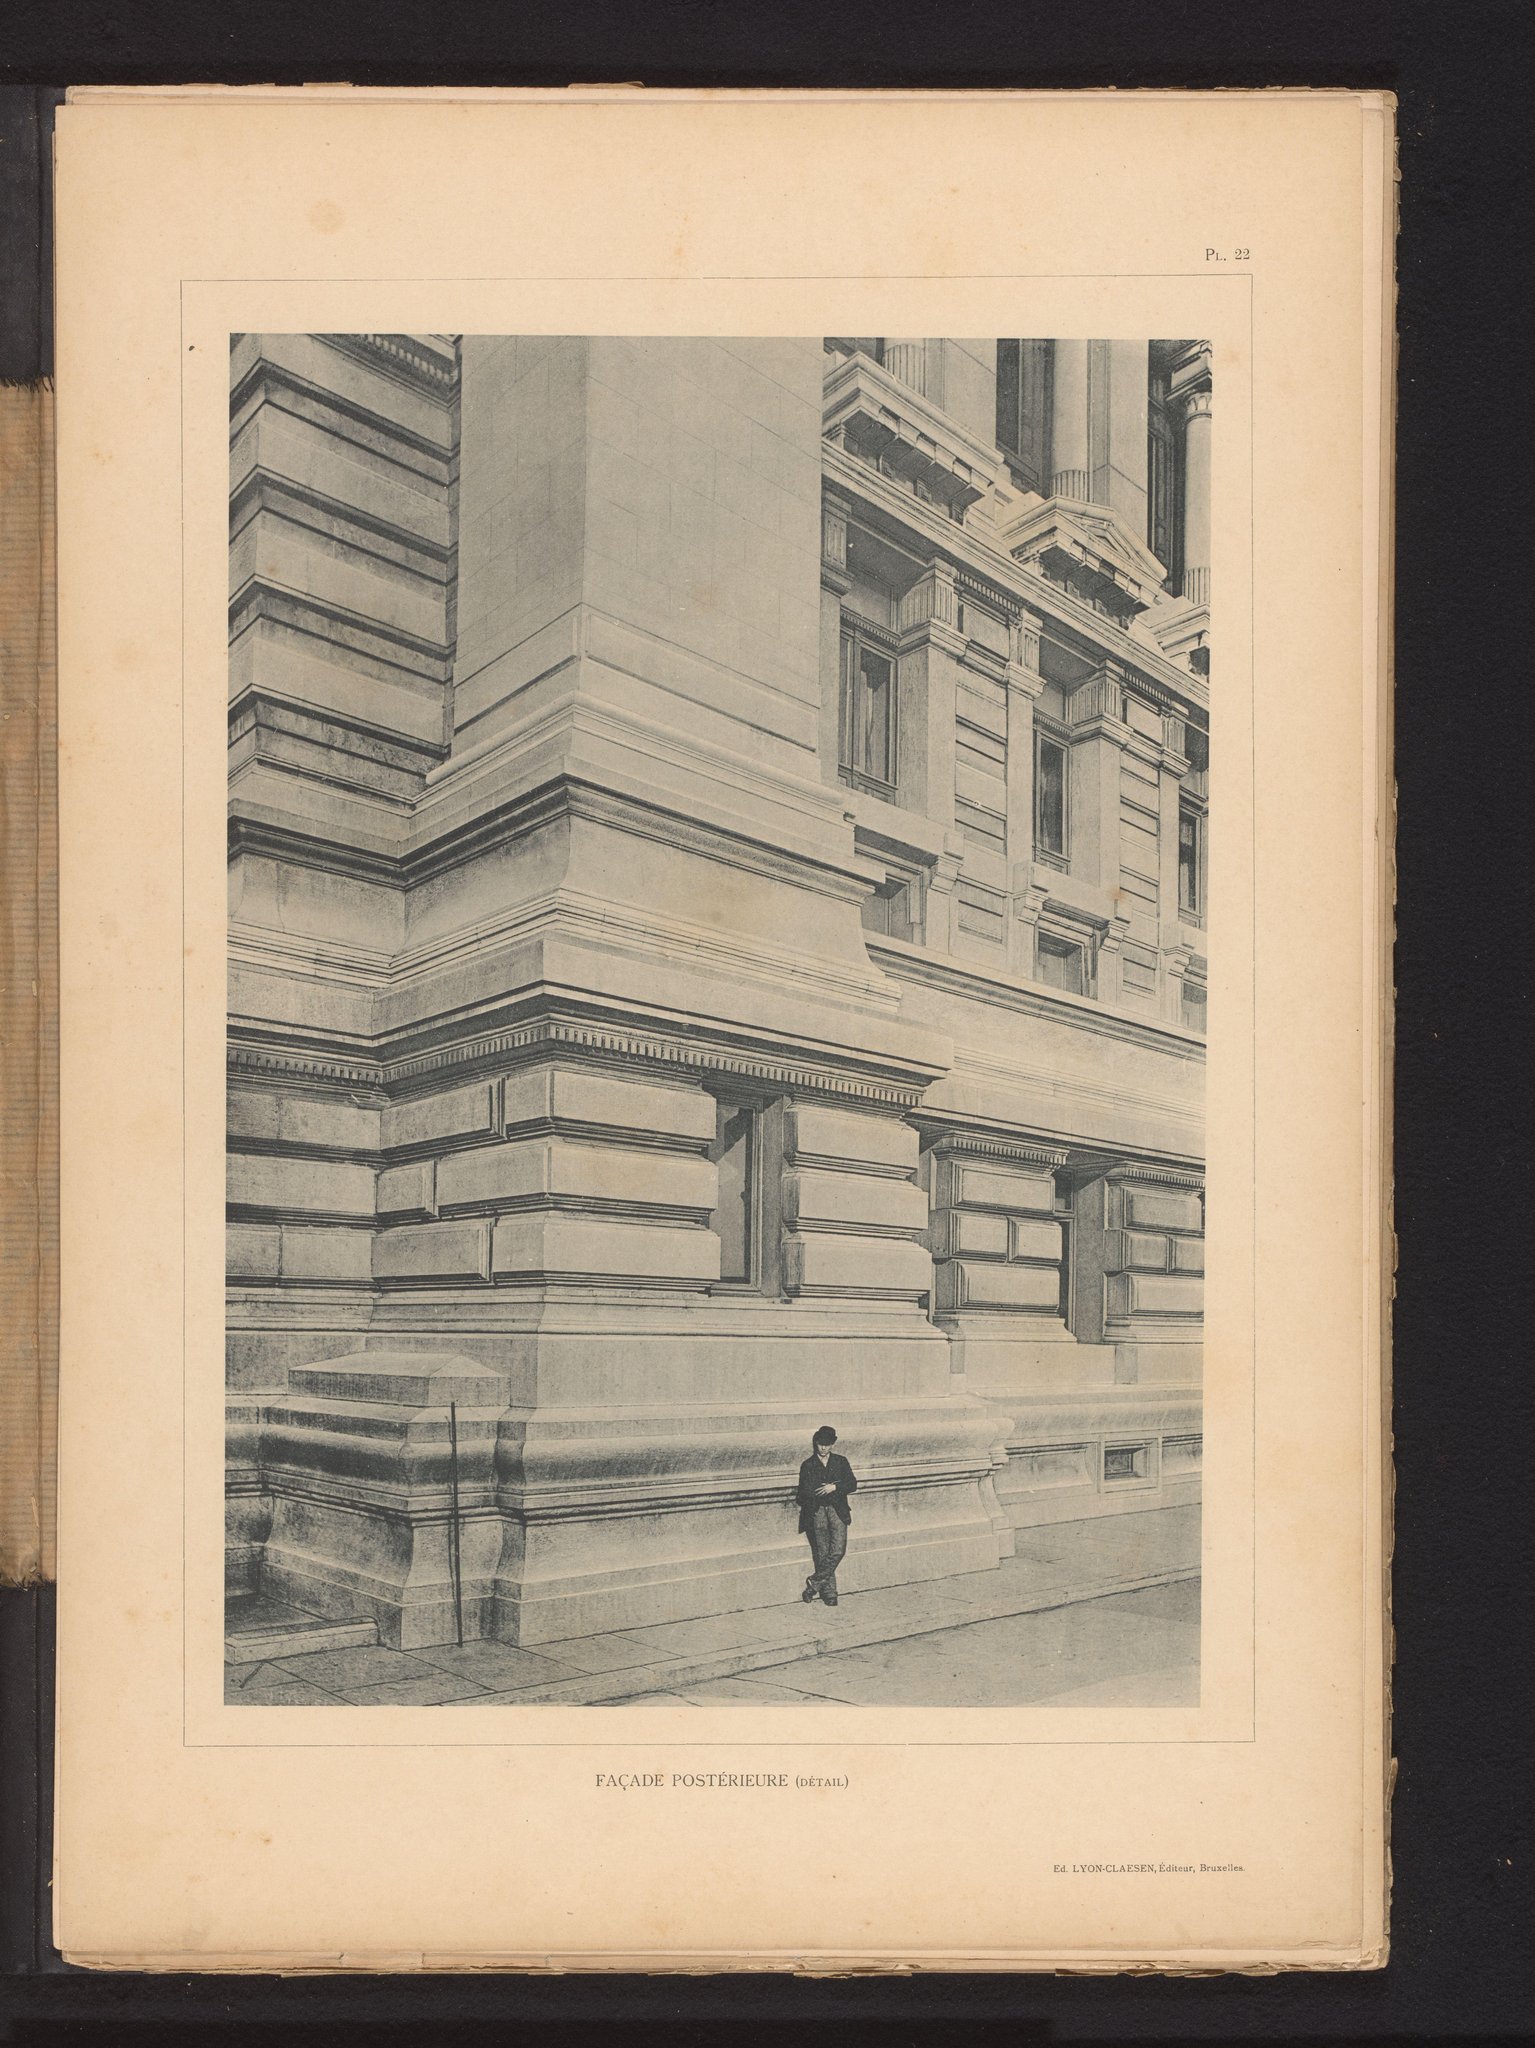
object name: photomechanical print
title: Man voor de achterzijde van het Paleis van Justitie in Brussel, België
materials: paper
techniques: photograph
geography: brussels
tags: court building, adult man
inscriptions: number: ‘PL. 22’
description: Deze prent maakt deel uit van een omslag met 30 prenten op 28 bladen en een titelblad.